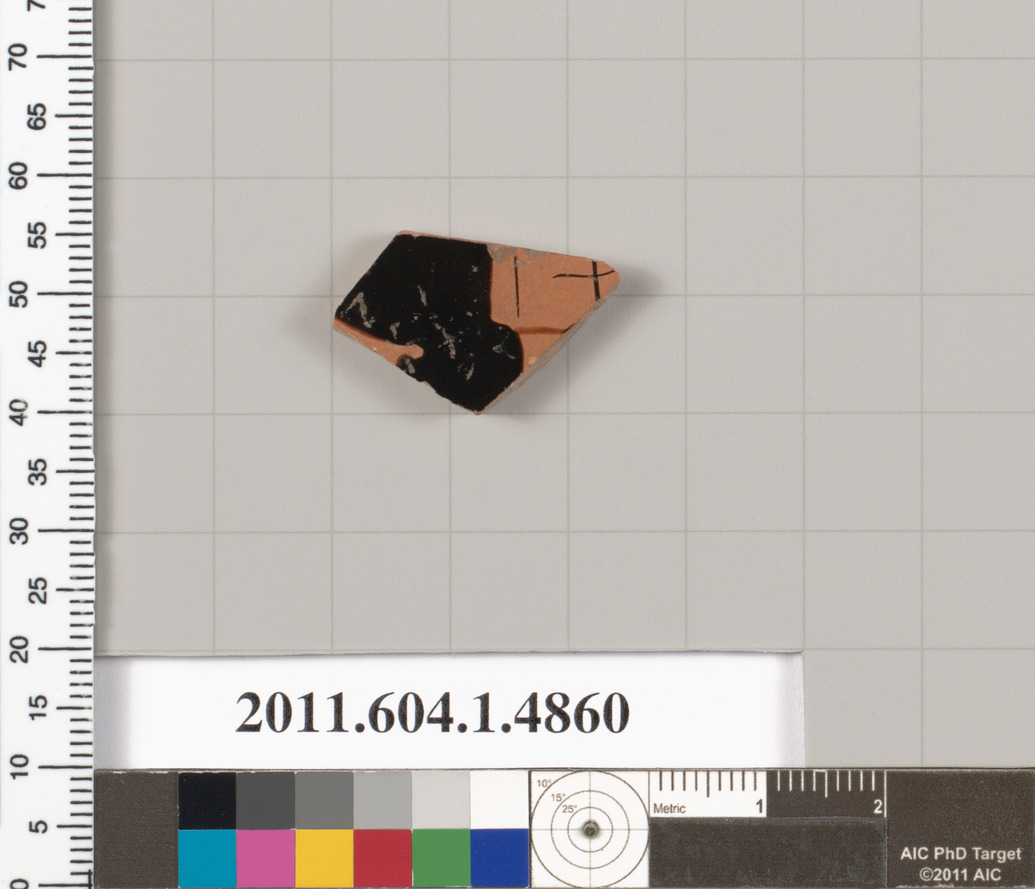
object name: kylix fragment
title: Terracotta fragment of a kylix (drinking cup)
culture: greek, attic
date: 467-435 BCE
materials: terracotta